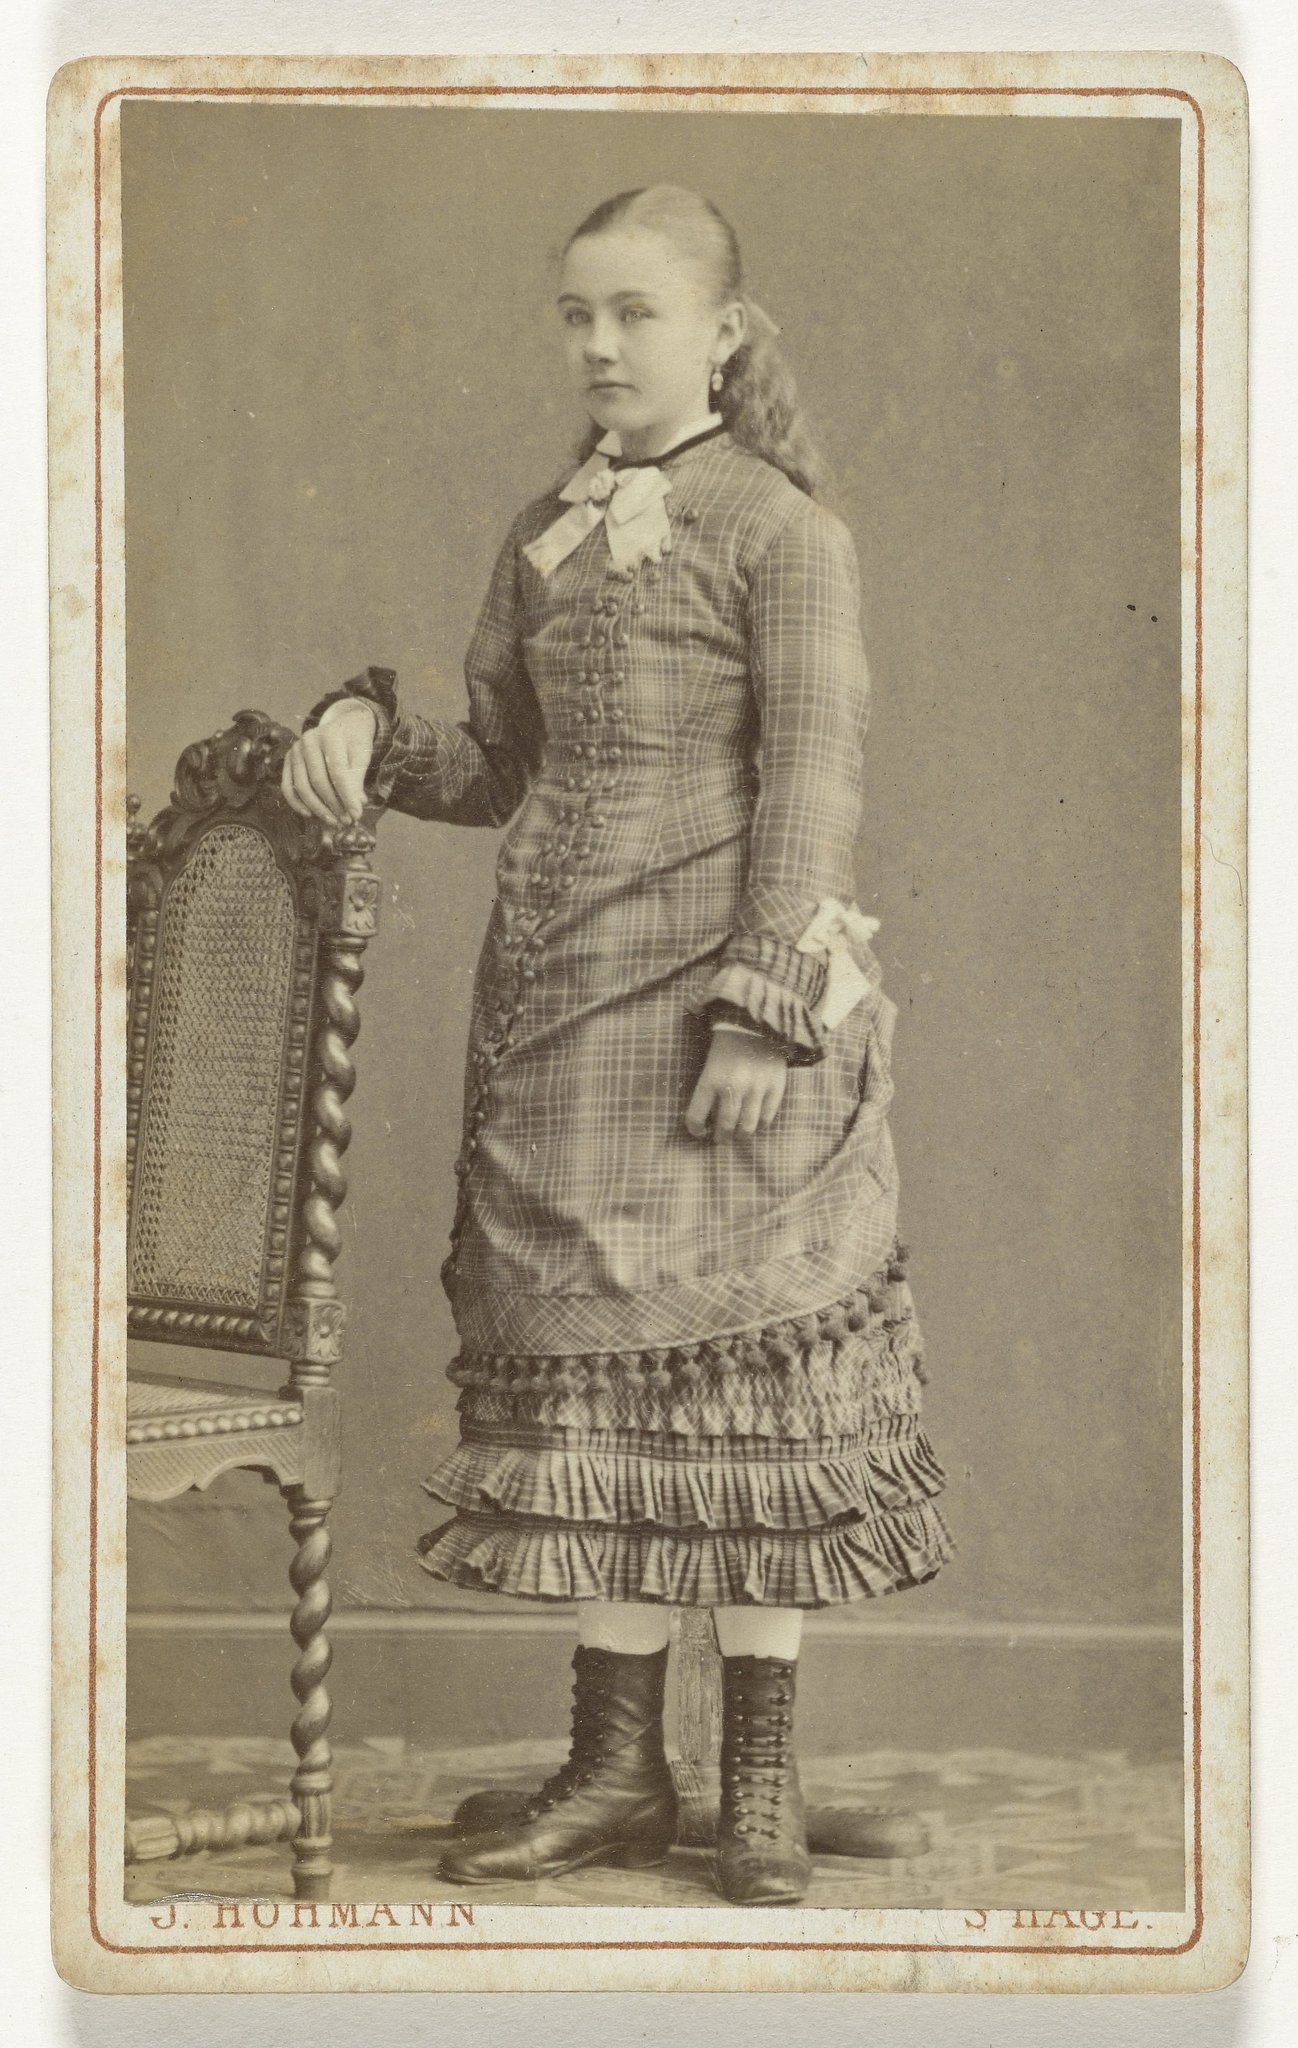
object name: photograph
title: Portret van een jong meisje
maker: jacob hohmann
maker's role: fotograaf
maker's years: 1833-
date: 1863-1879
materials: cardboard, paper, photographic support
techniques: albumen print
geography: the hague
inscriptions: signature and address: ‘H/Photographisch Atelier/van/J. Hohmann/Willemstraat 59,/'s Gravenhage’, annotation: ‘Voor nabestellingen worden alle negatieven bewaard.’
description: Jong meisje in een geruite japon met stroken onderaan, staand naast een stoel.